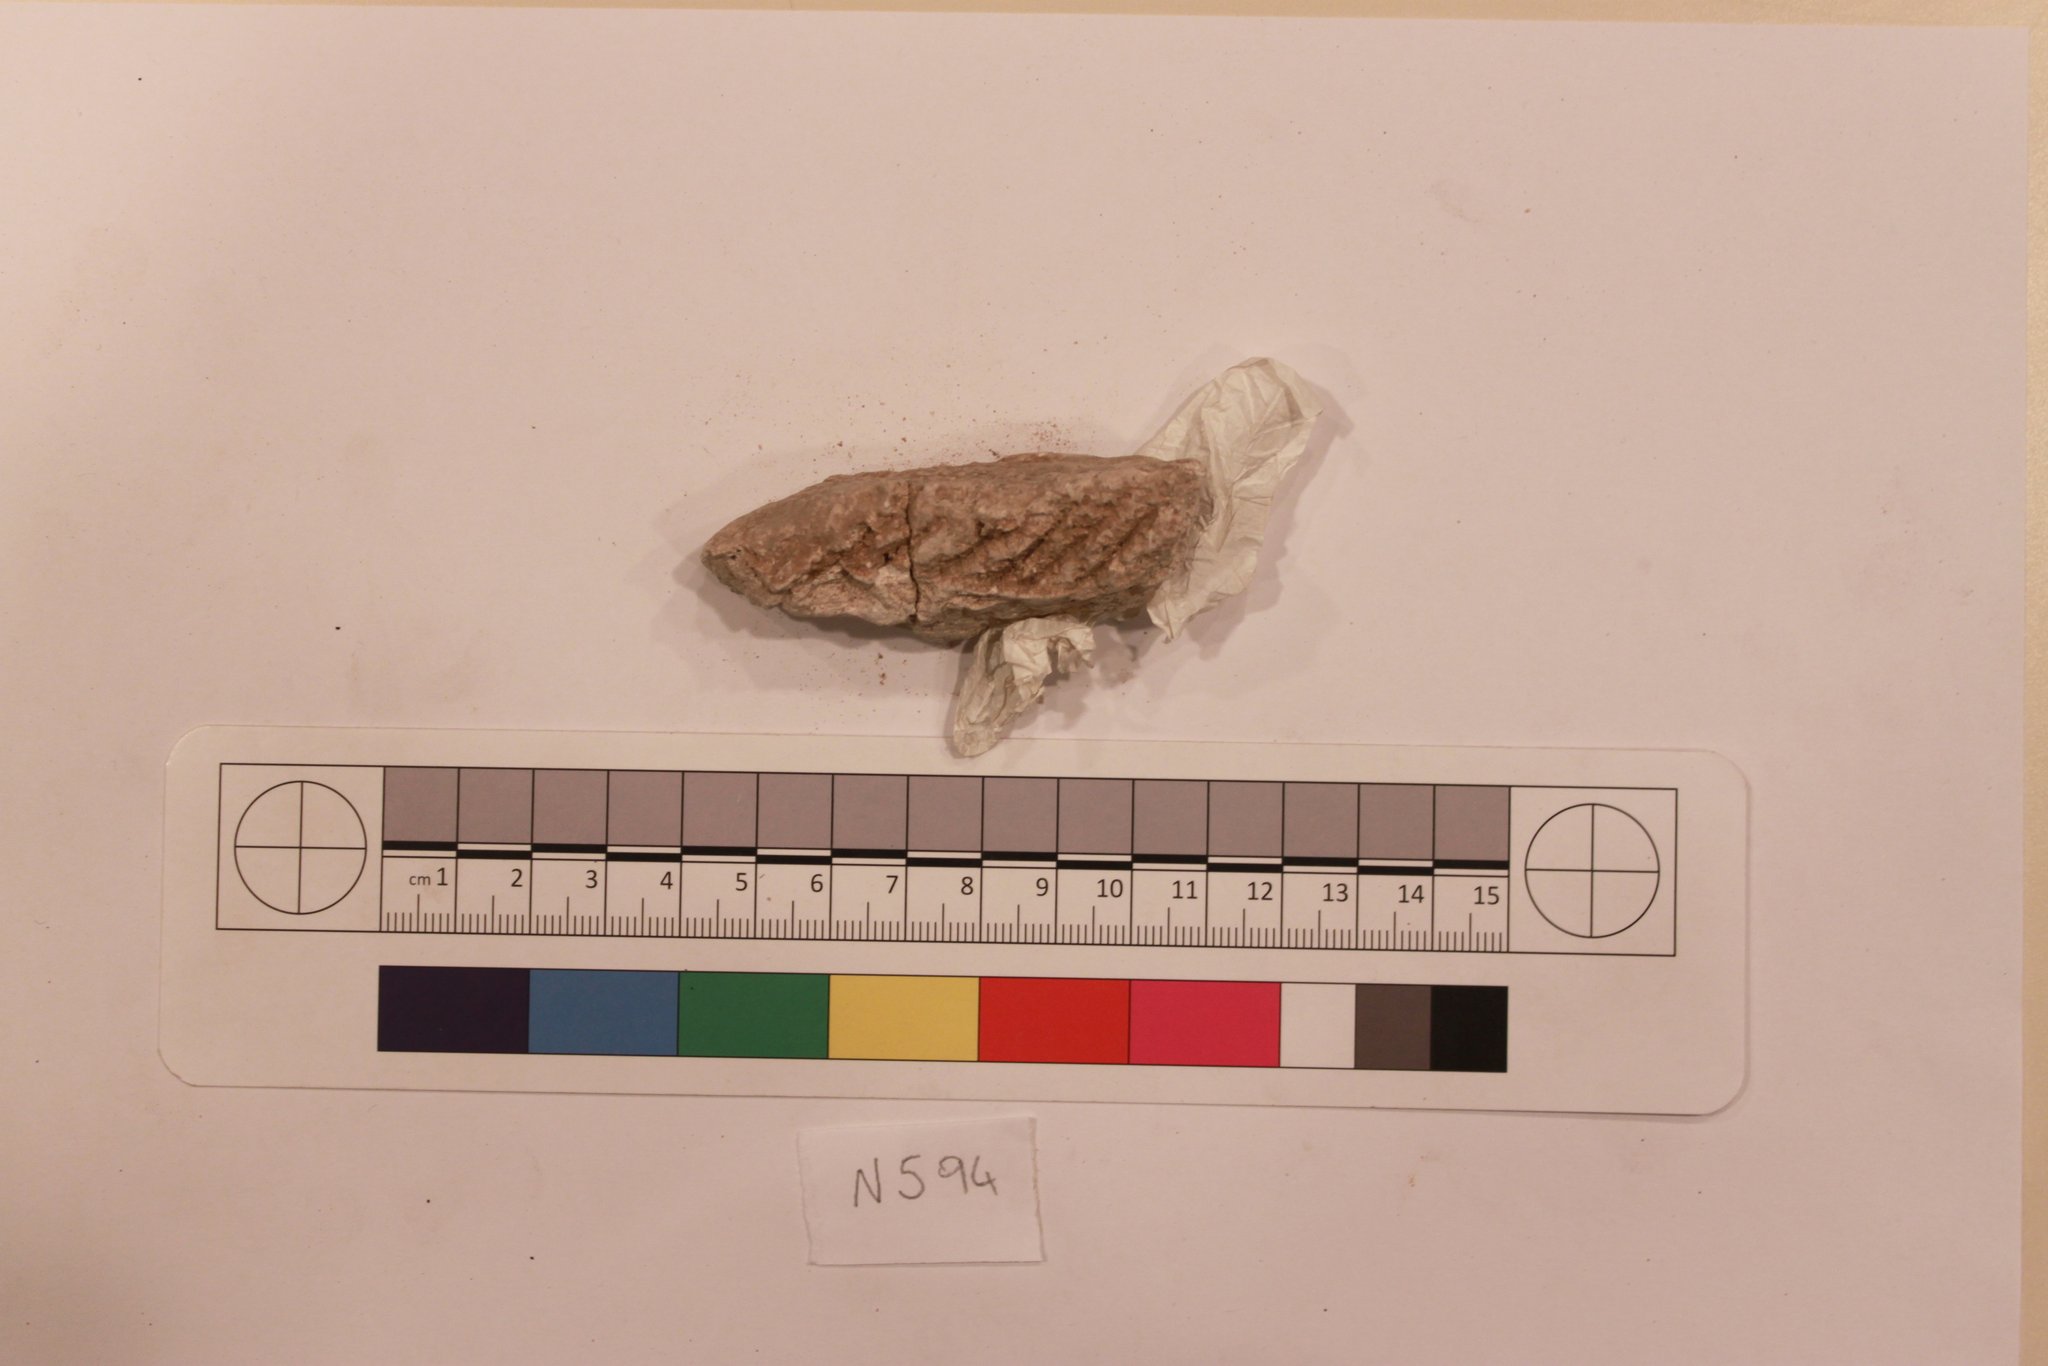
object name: fragment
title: Stucco Fragment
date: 701-1200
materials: plaster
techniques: carving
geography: iran